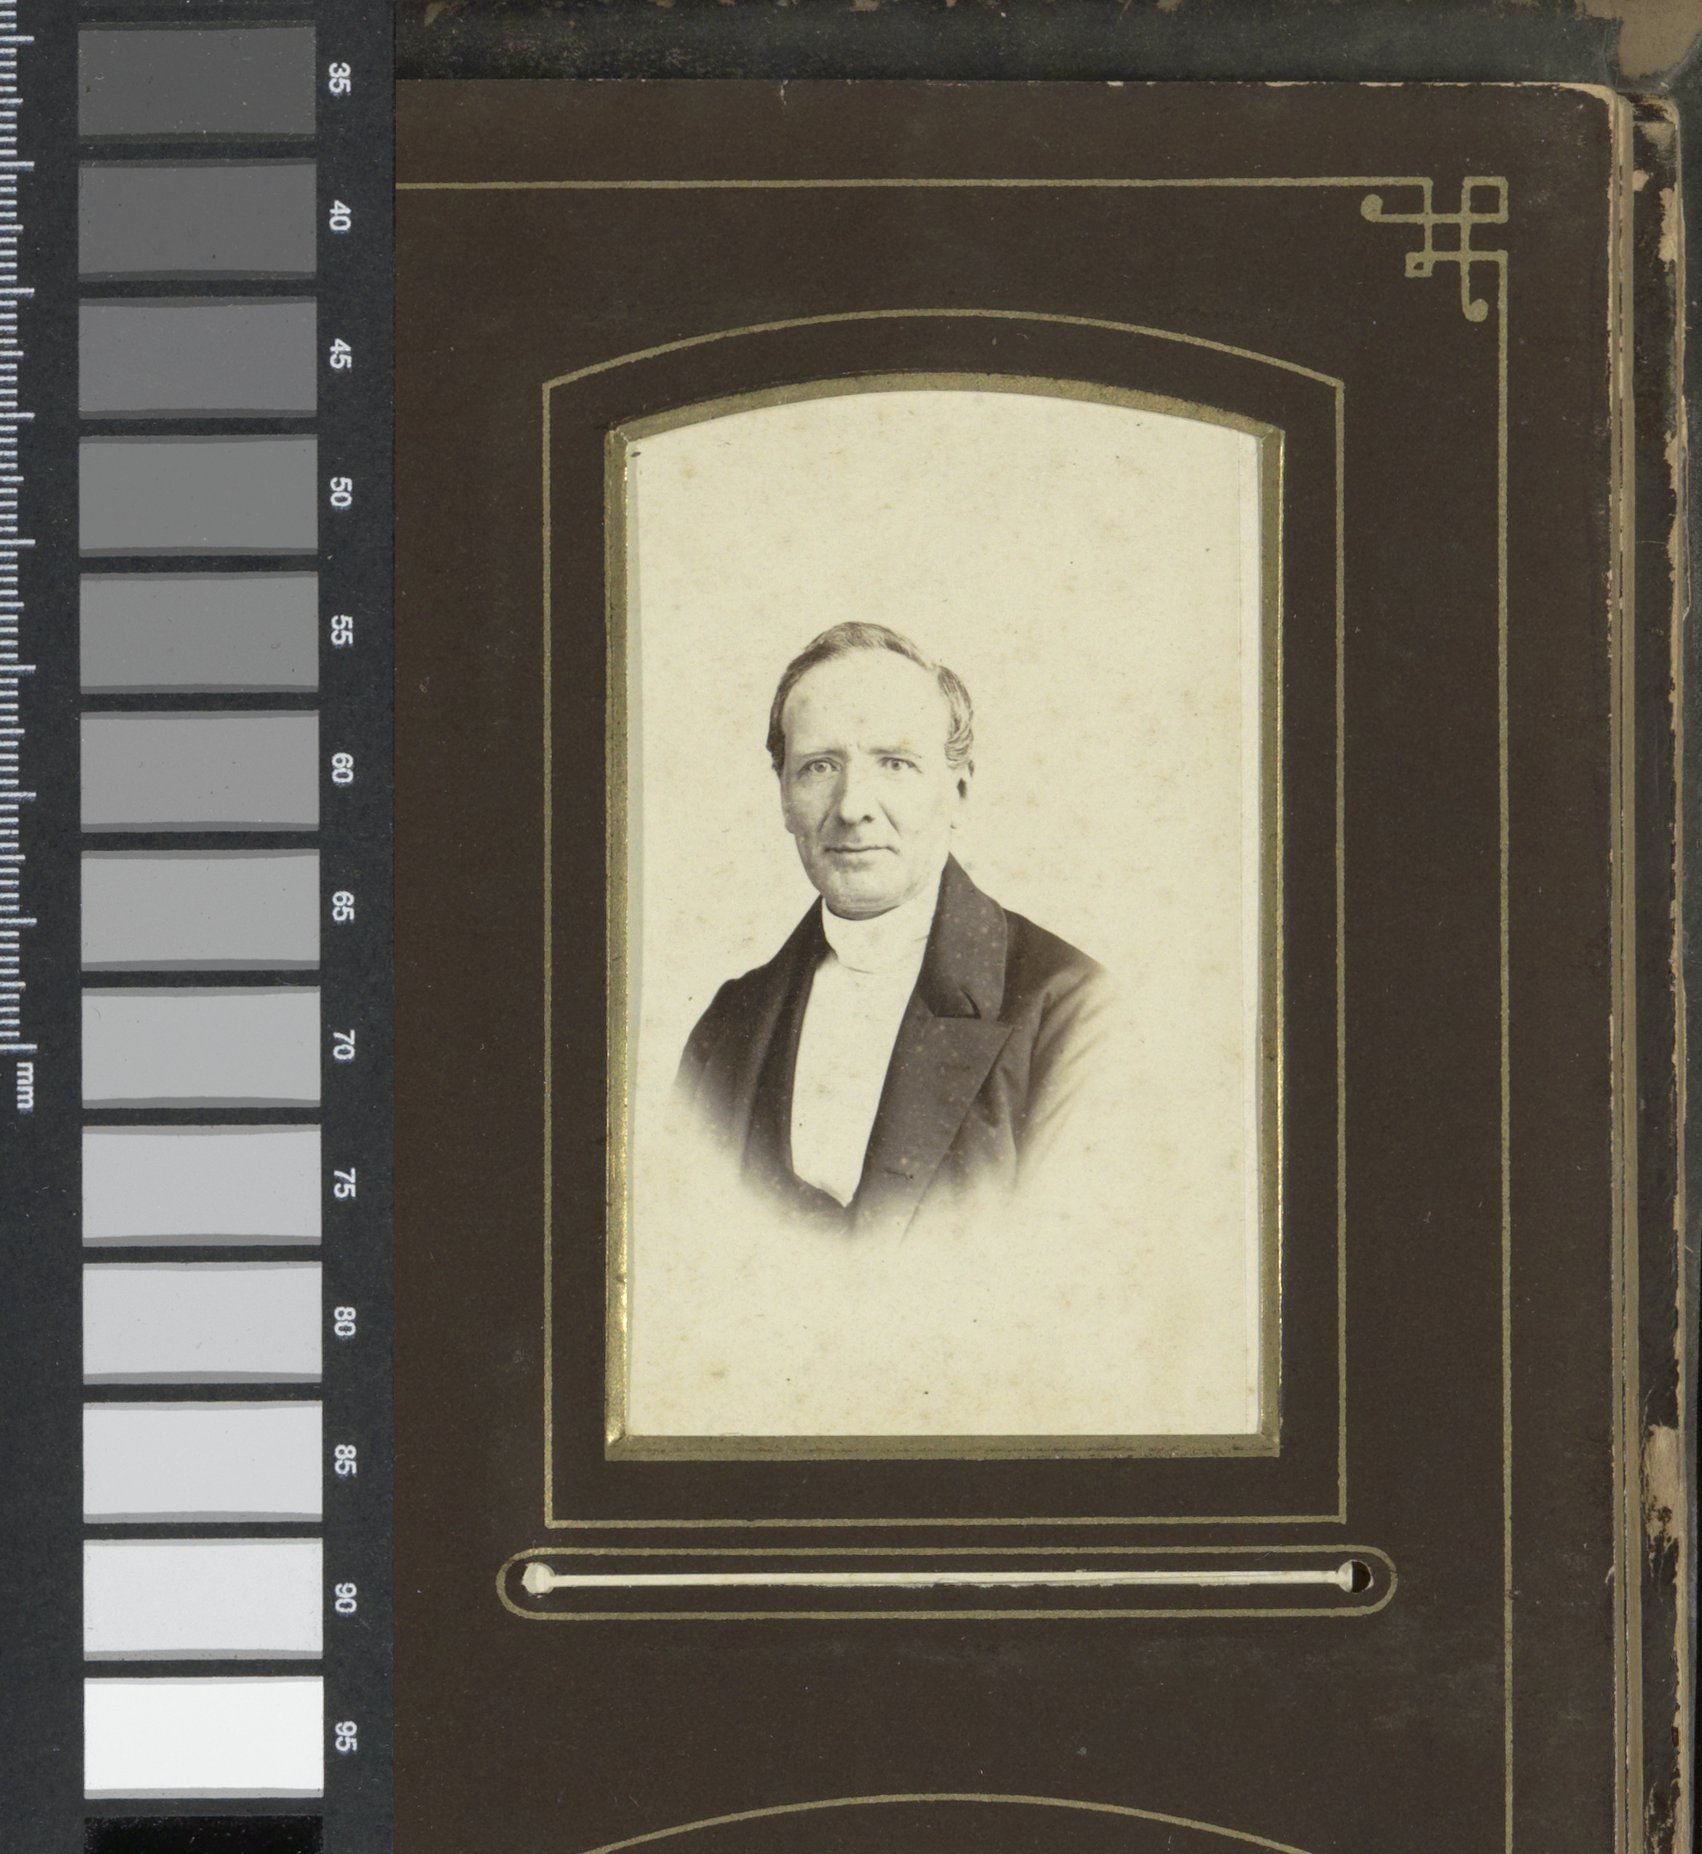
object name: photograph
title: Portret van een man met een jas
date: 1863-1899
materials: cardboard, paper, photographic support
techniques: albumen print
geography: delft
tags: adult man, historical persons not known by name, delft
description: Onderdeel van Fotoalbum van de families Matthes, Doorman en Van Thiel.